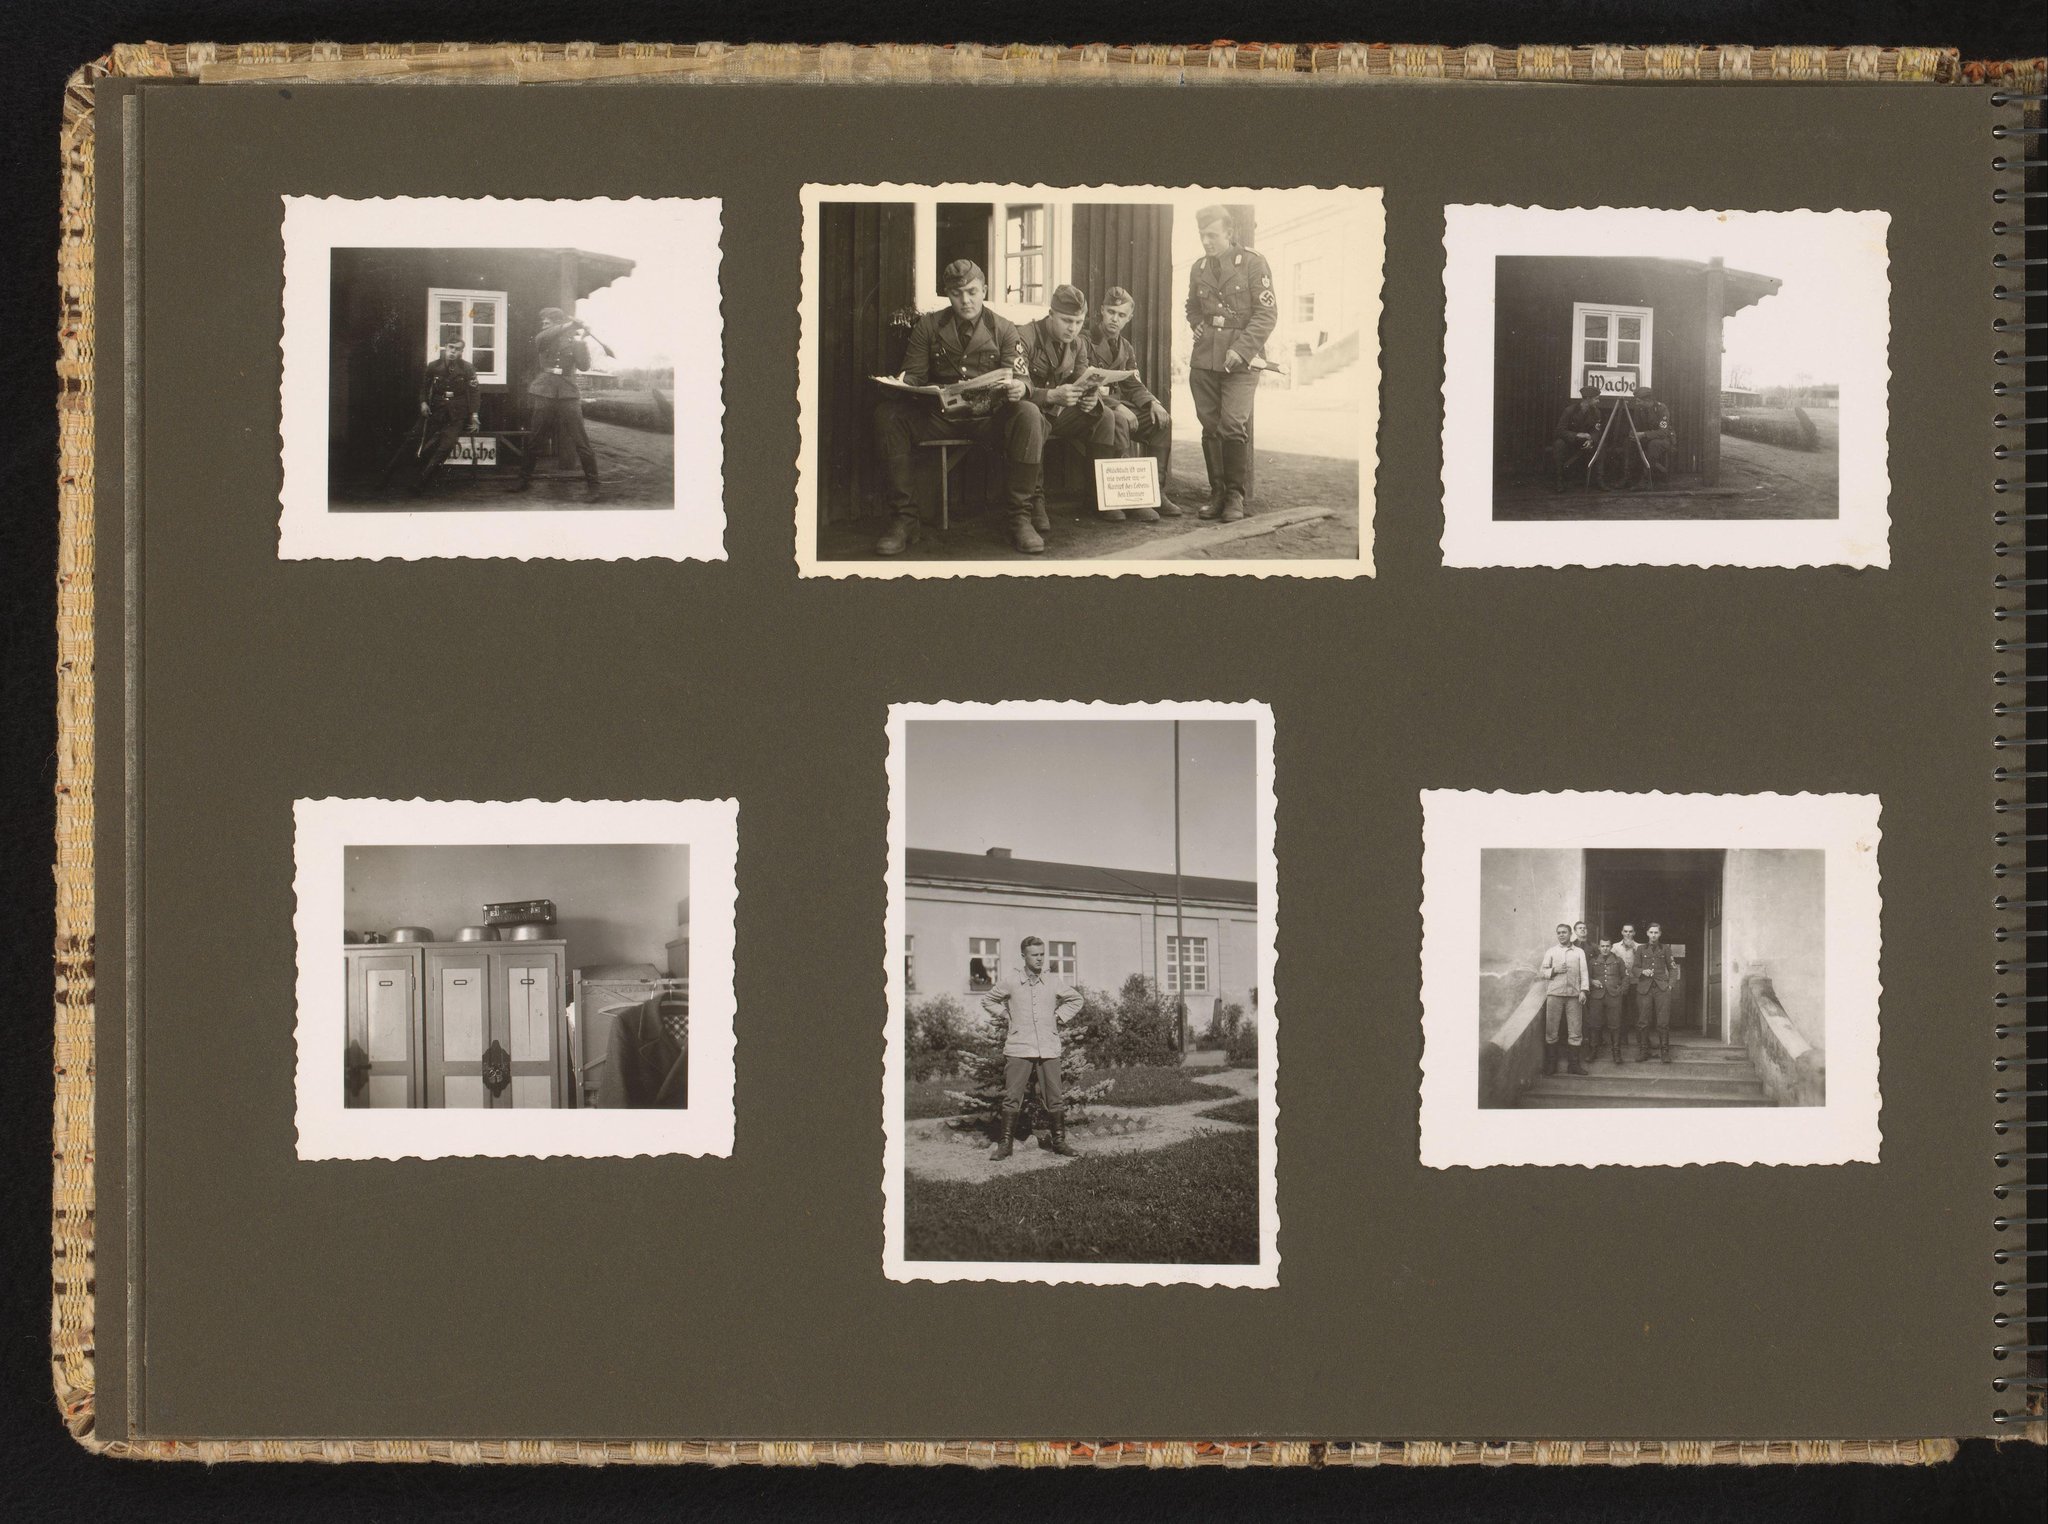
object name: photograph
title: Soldatenleven tijdens de opleiding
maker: Anonymous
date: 1935-1940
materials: cardboard, photographic support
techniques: gelatin silver print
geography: germany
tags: military training, germany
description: Albumblad met zes foto's van het soldatenleven tijdens de opleiding bij de Reichsarbeitsdienst: in en om de kazerne, geinen met medesoldaten. Onderdeel van het fotoalbum Duitse bezetting van Nederland.